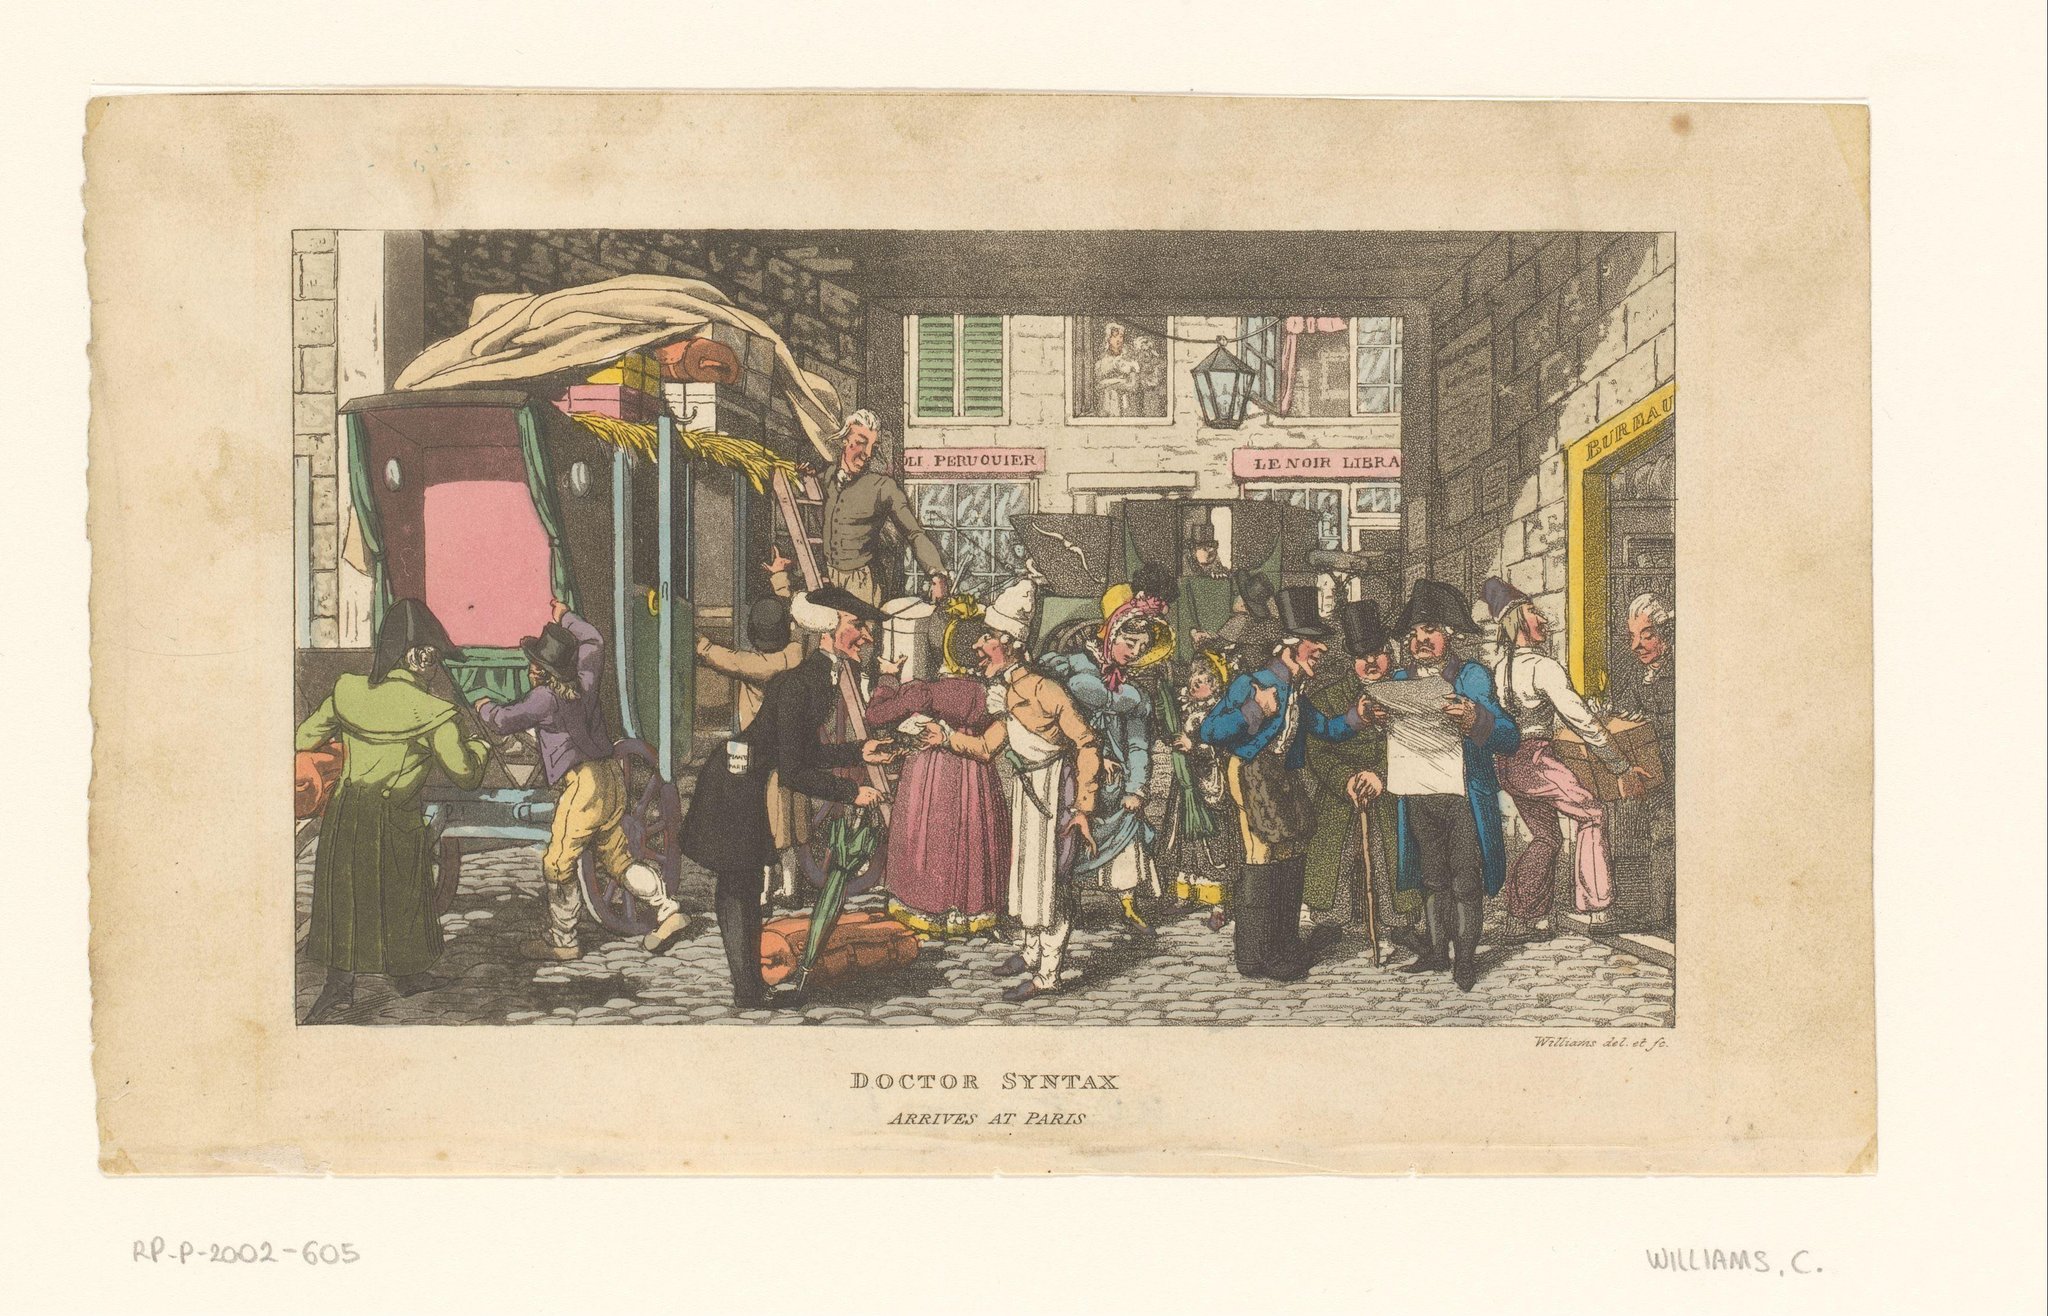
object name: book illustration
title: Doctor Syntax arrives at Paris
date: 1820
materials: paper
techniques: aquatint, etching, hand coloring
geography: london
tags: names of literary characters, four-wheeled, animal-drawn vehicle, e.g.: cab, carriage, coach, arrival and return ~ travelling, paris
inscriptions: collector's mark: Lugt 2228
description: Prent ook gebruikt in: Doctor Syntax in Paris or A Tour in search of the Grotesque. A humorous & satirical poem. Londen: W. Wright, 1820.